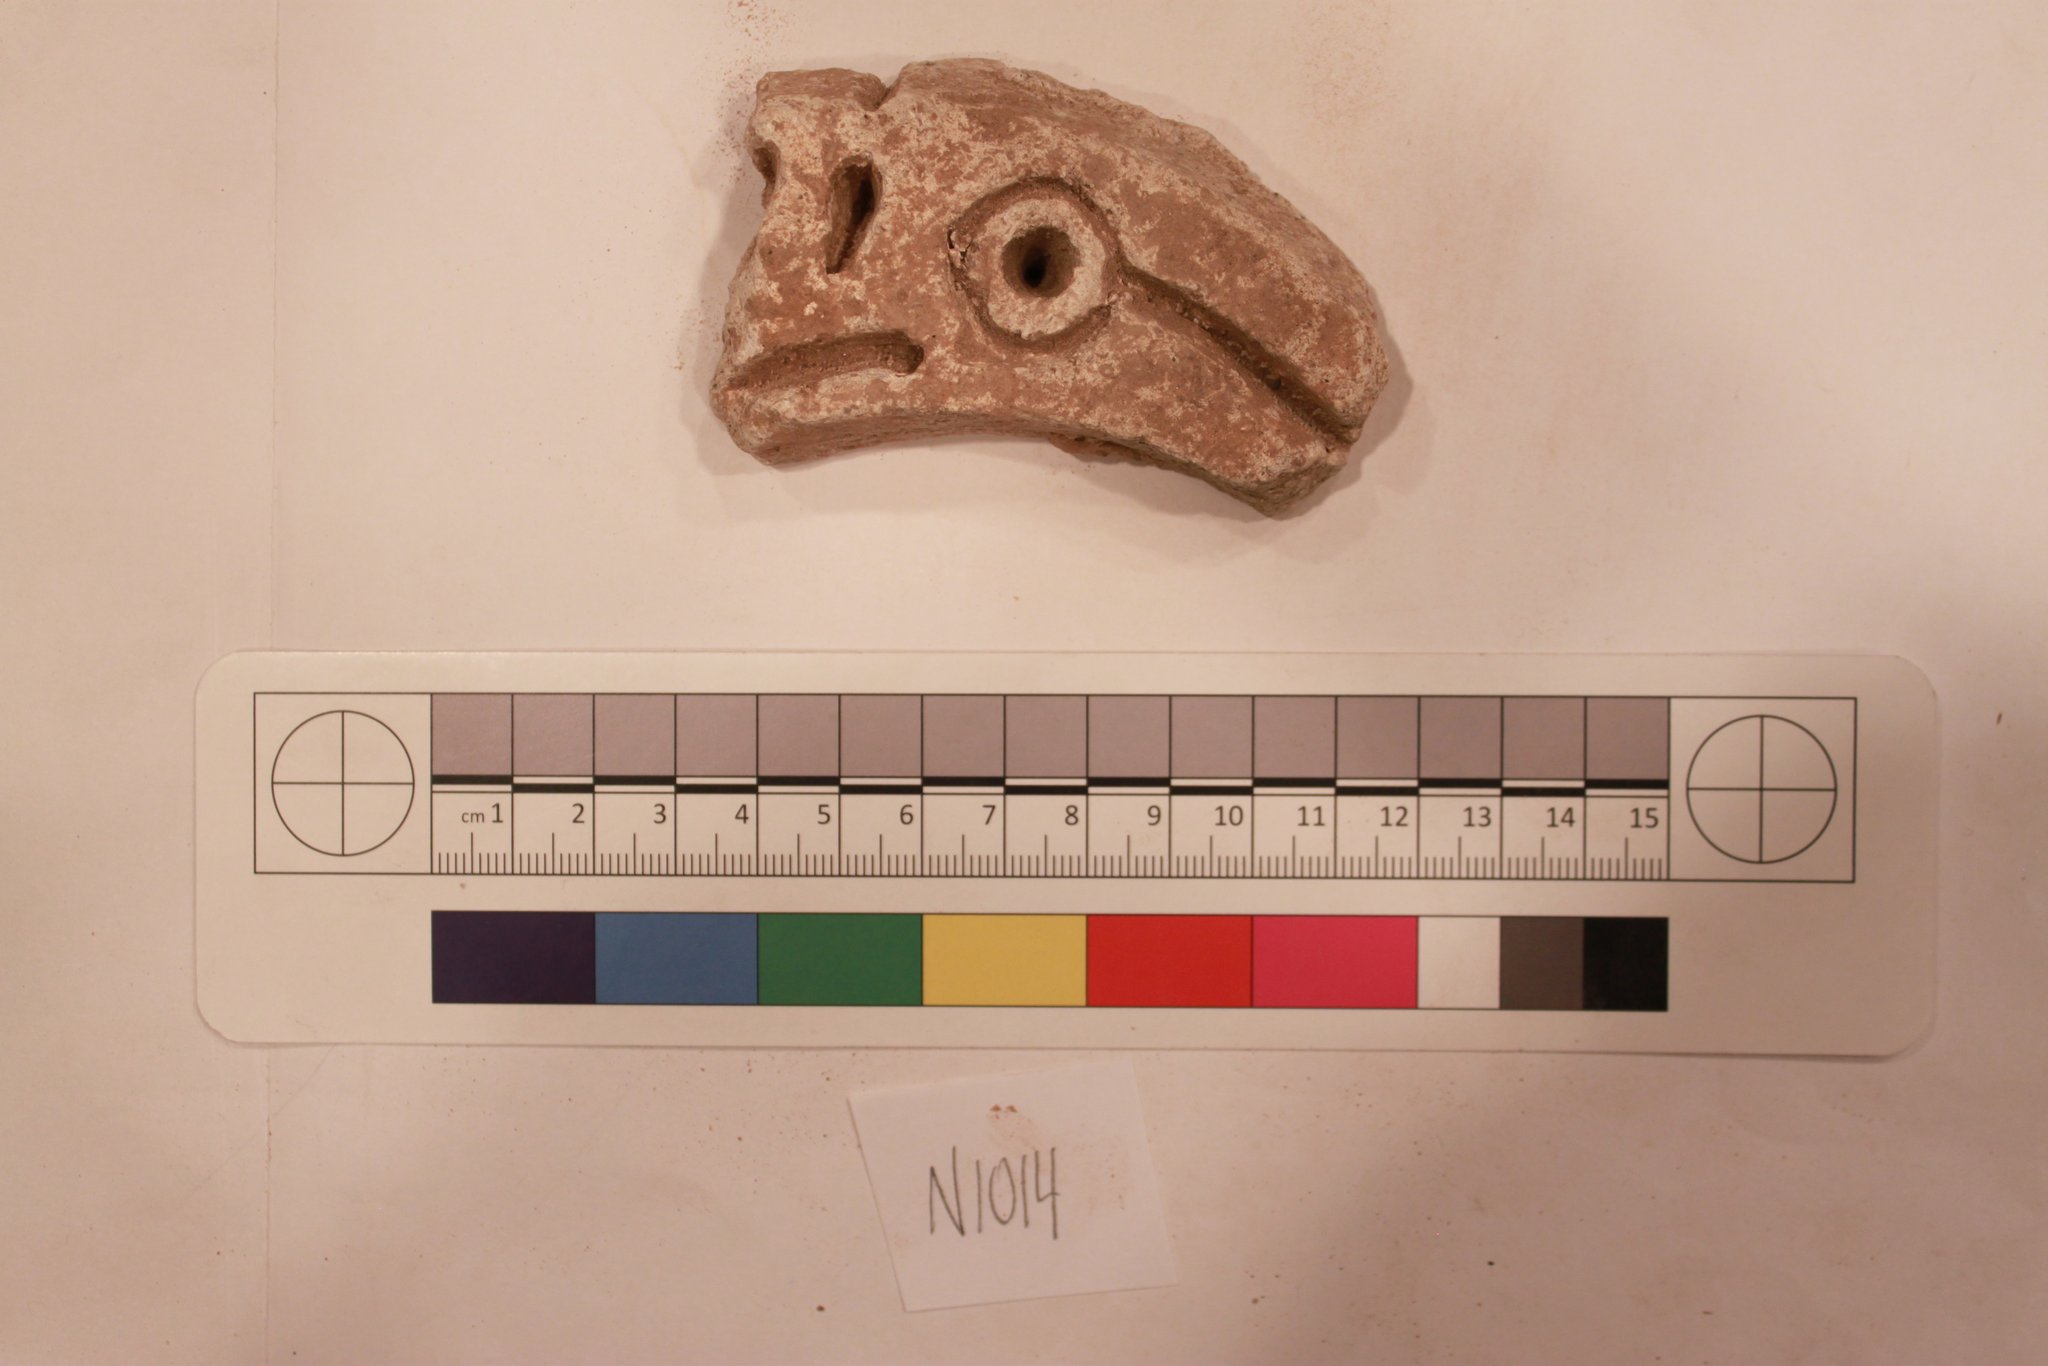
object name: fragment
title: Stucco Fragment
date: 701-1200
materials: plaster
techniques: carving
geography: iran